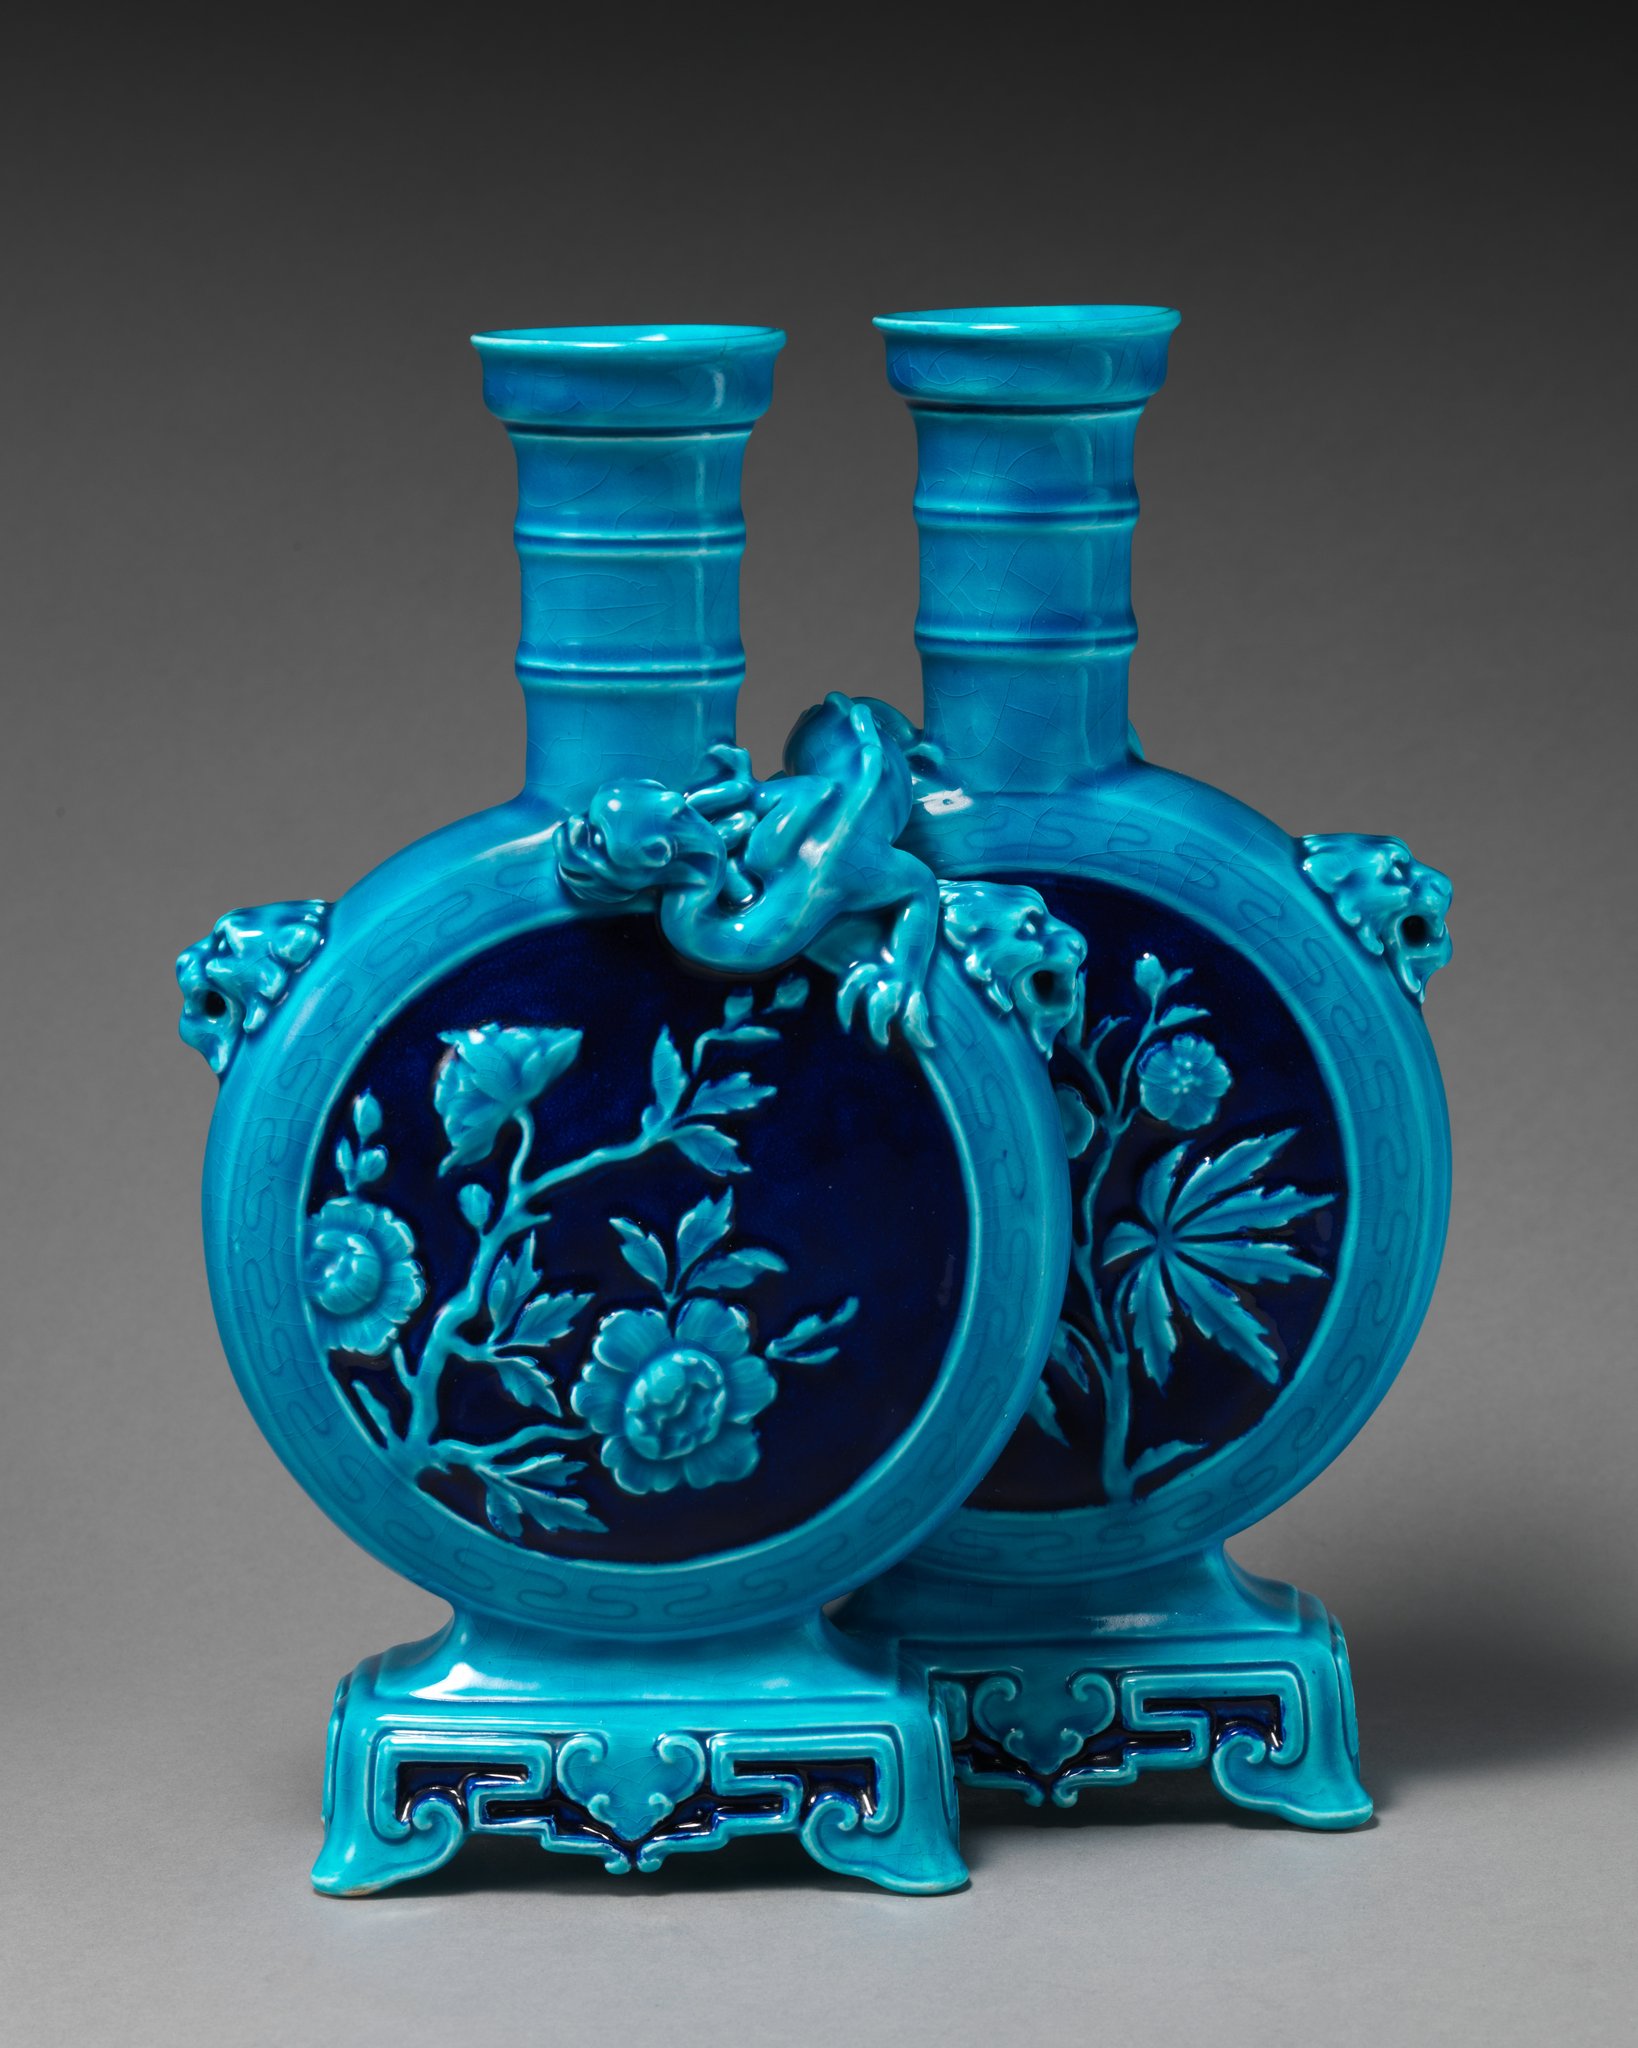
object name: moon flask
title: Double moon flask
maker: minton(s)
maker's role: maker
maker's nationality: british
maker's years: 1793-2001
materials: earthenware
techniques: glazing